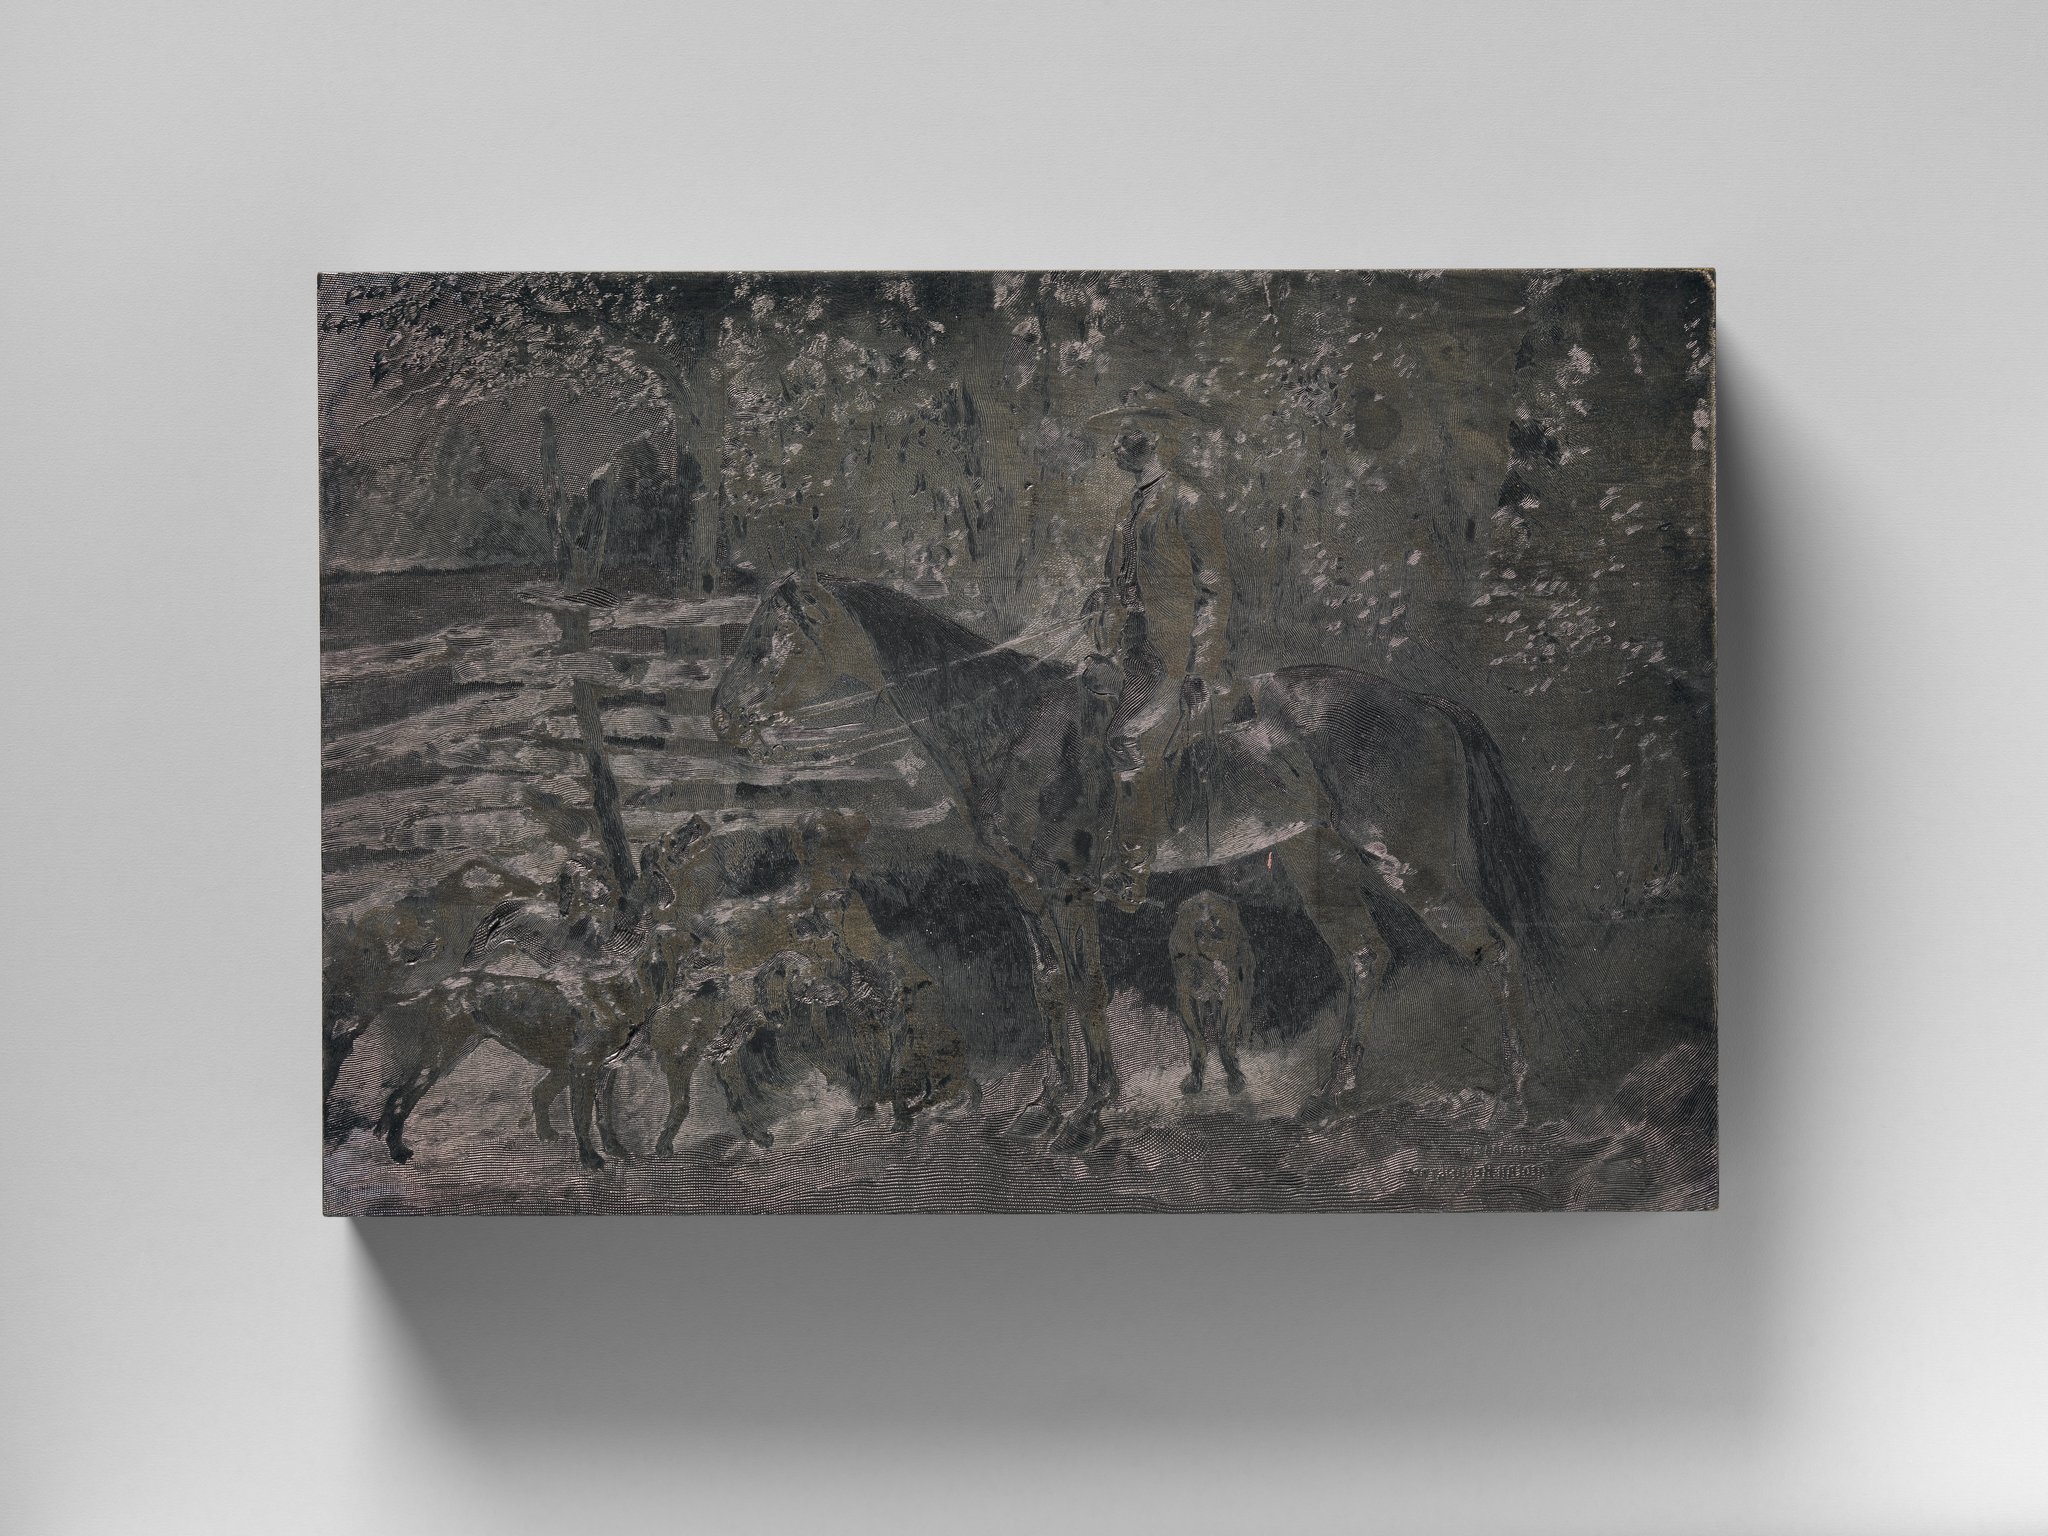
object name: block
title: A Southern Rider, from "Some American Riders," for "Harper's New Monthly Magazine," August 1891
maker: frederic remington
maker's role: artist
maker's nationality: american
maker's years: 1861-1909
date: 1891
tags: animals,men,horses